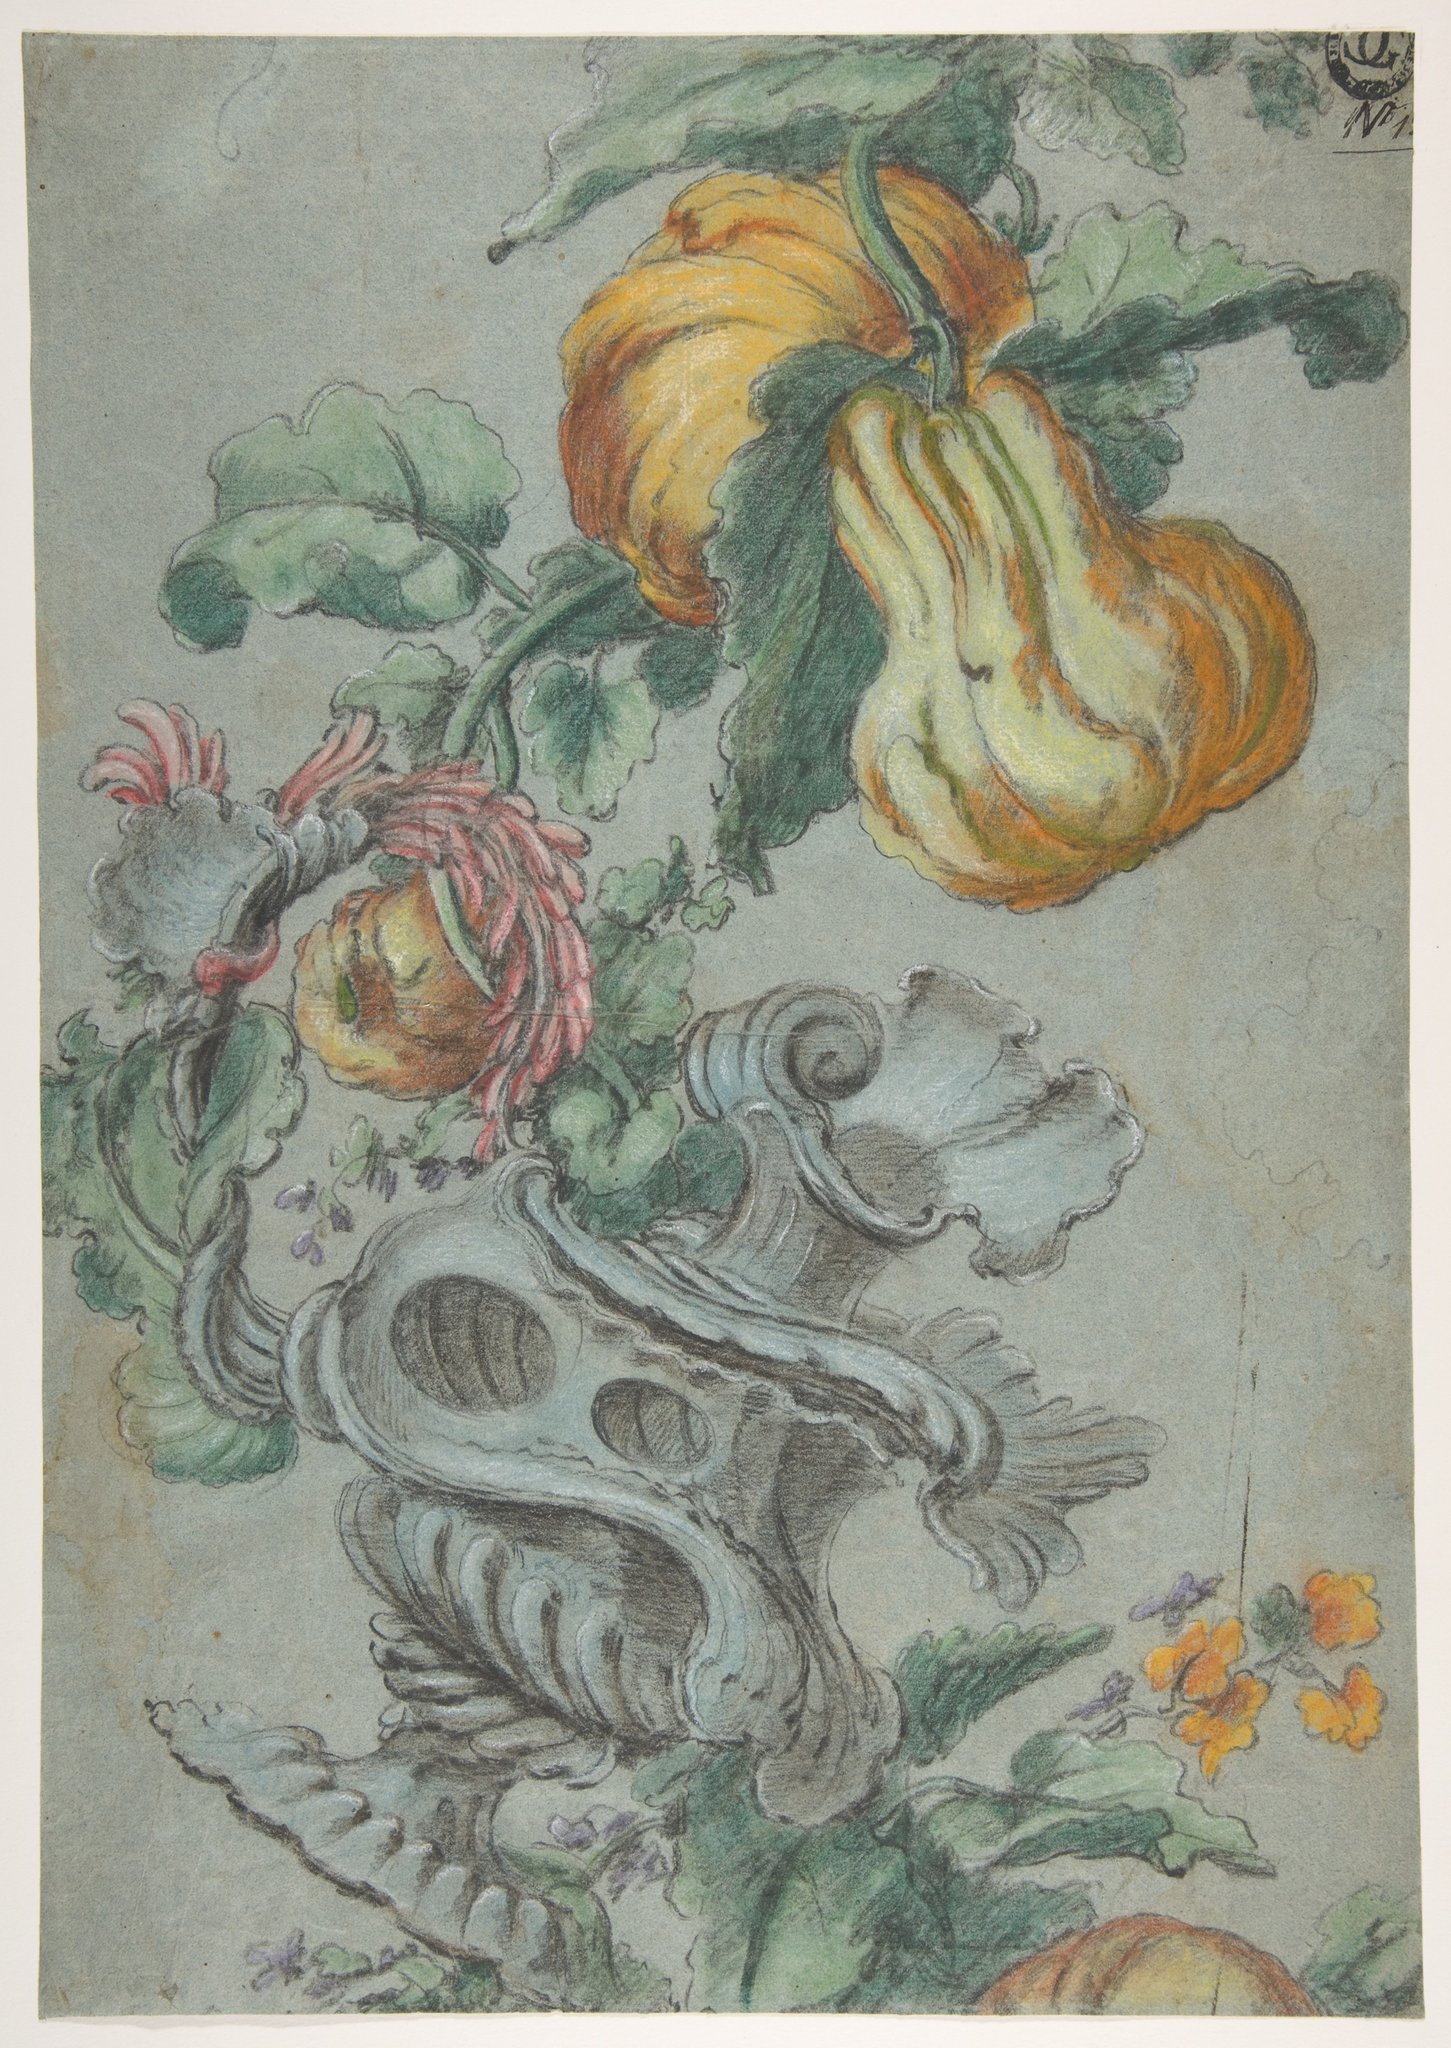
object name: drawing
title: Ornamental Design with Fruit and Flowers (recto); Flower Stalk with Leaves (verso)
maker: alexis peyrotte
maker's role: artist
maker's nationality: french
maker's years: 1699-1769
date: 1701-1800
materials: chalk, paper, pastel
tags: fruit,flowers